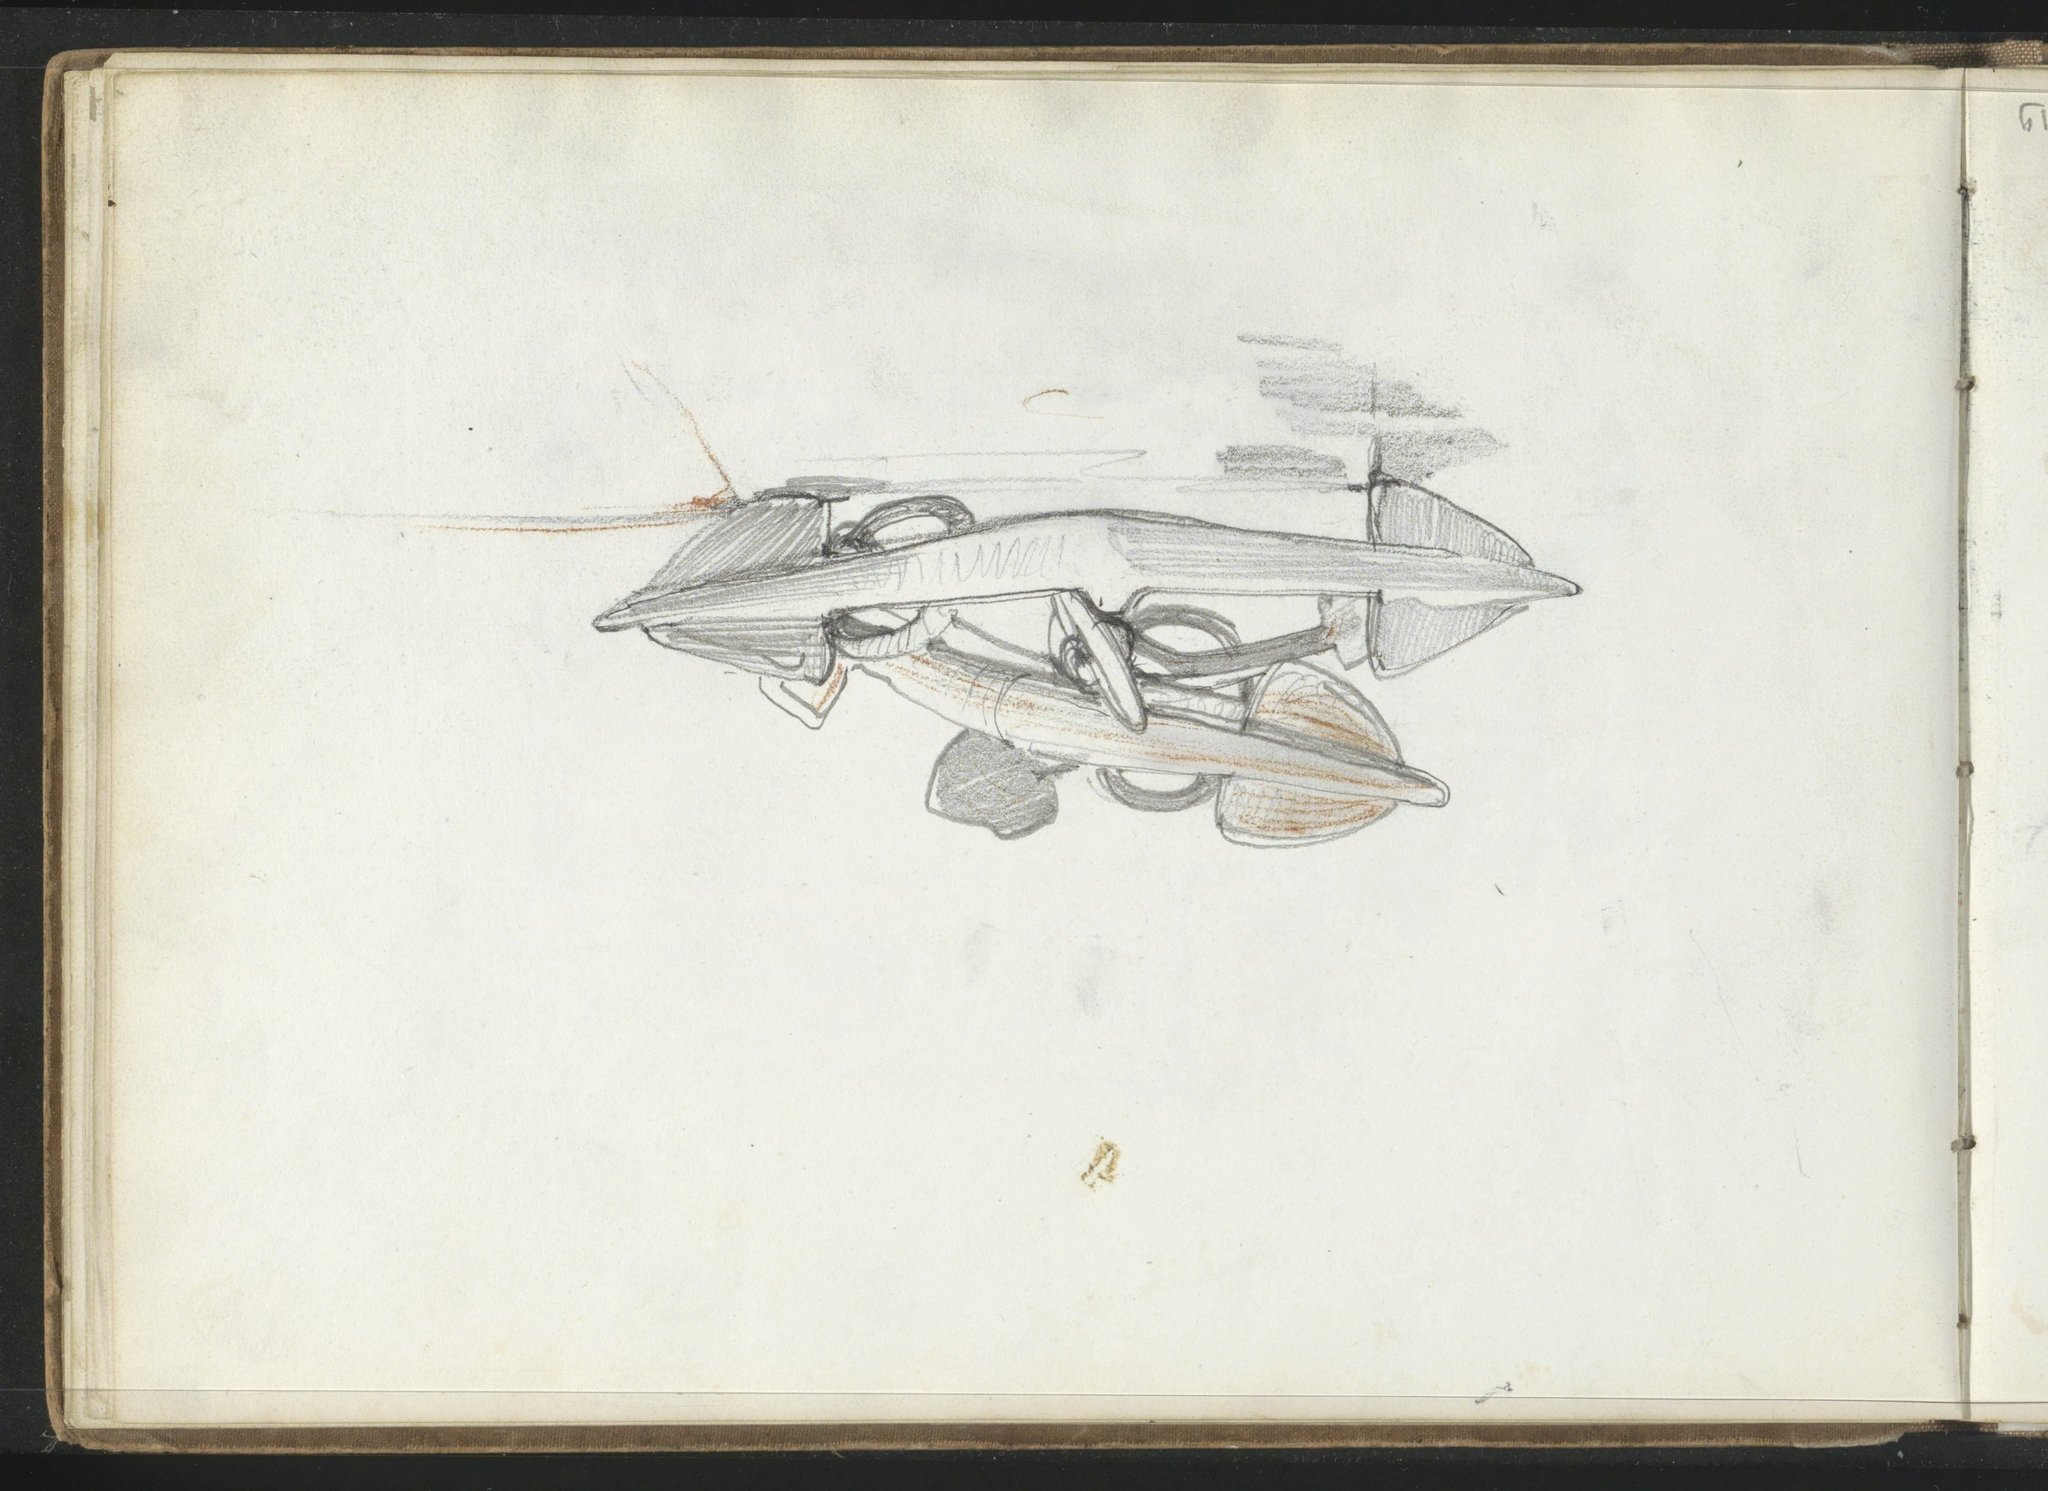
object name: sketchbook leaf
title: Anker van een schip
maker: johannes bosboom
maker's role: draughtsman, painter, print maker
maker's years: 1817-1891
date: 1827-1891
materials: chalk, paper, pencil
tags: parts of ship's exterior: anchor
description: Blad 14 verso uit een schetsboek met 41 pagina's.